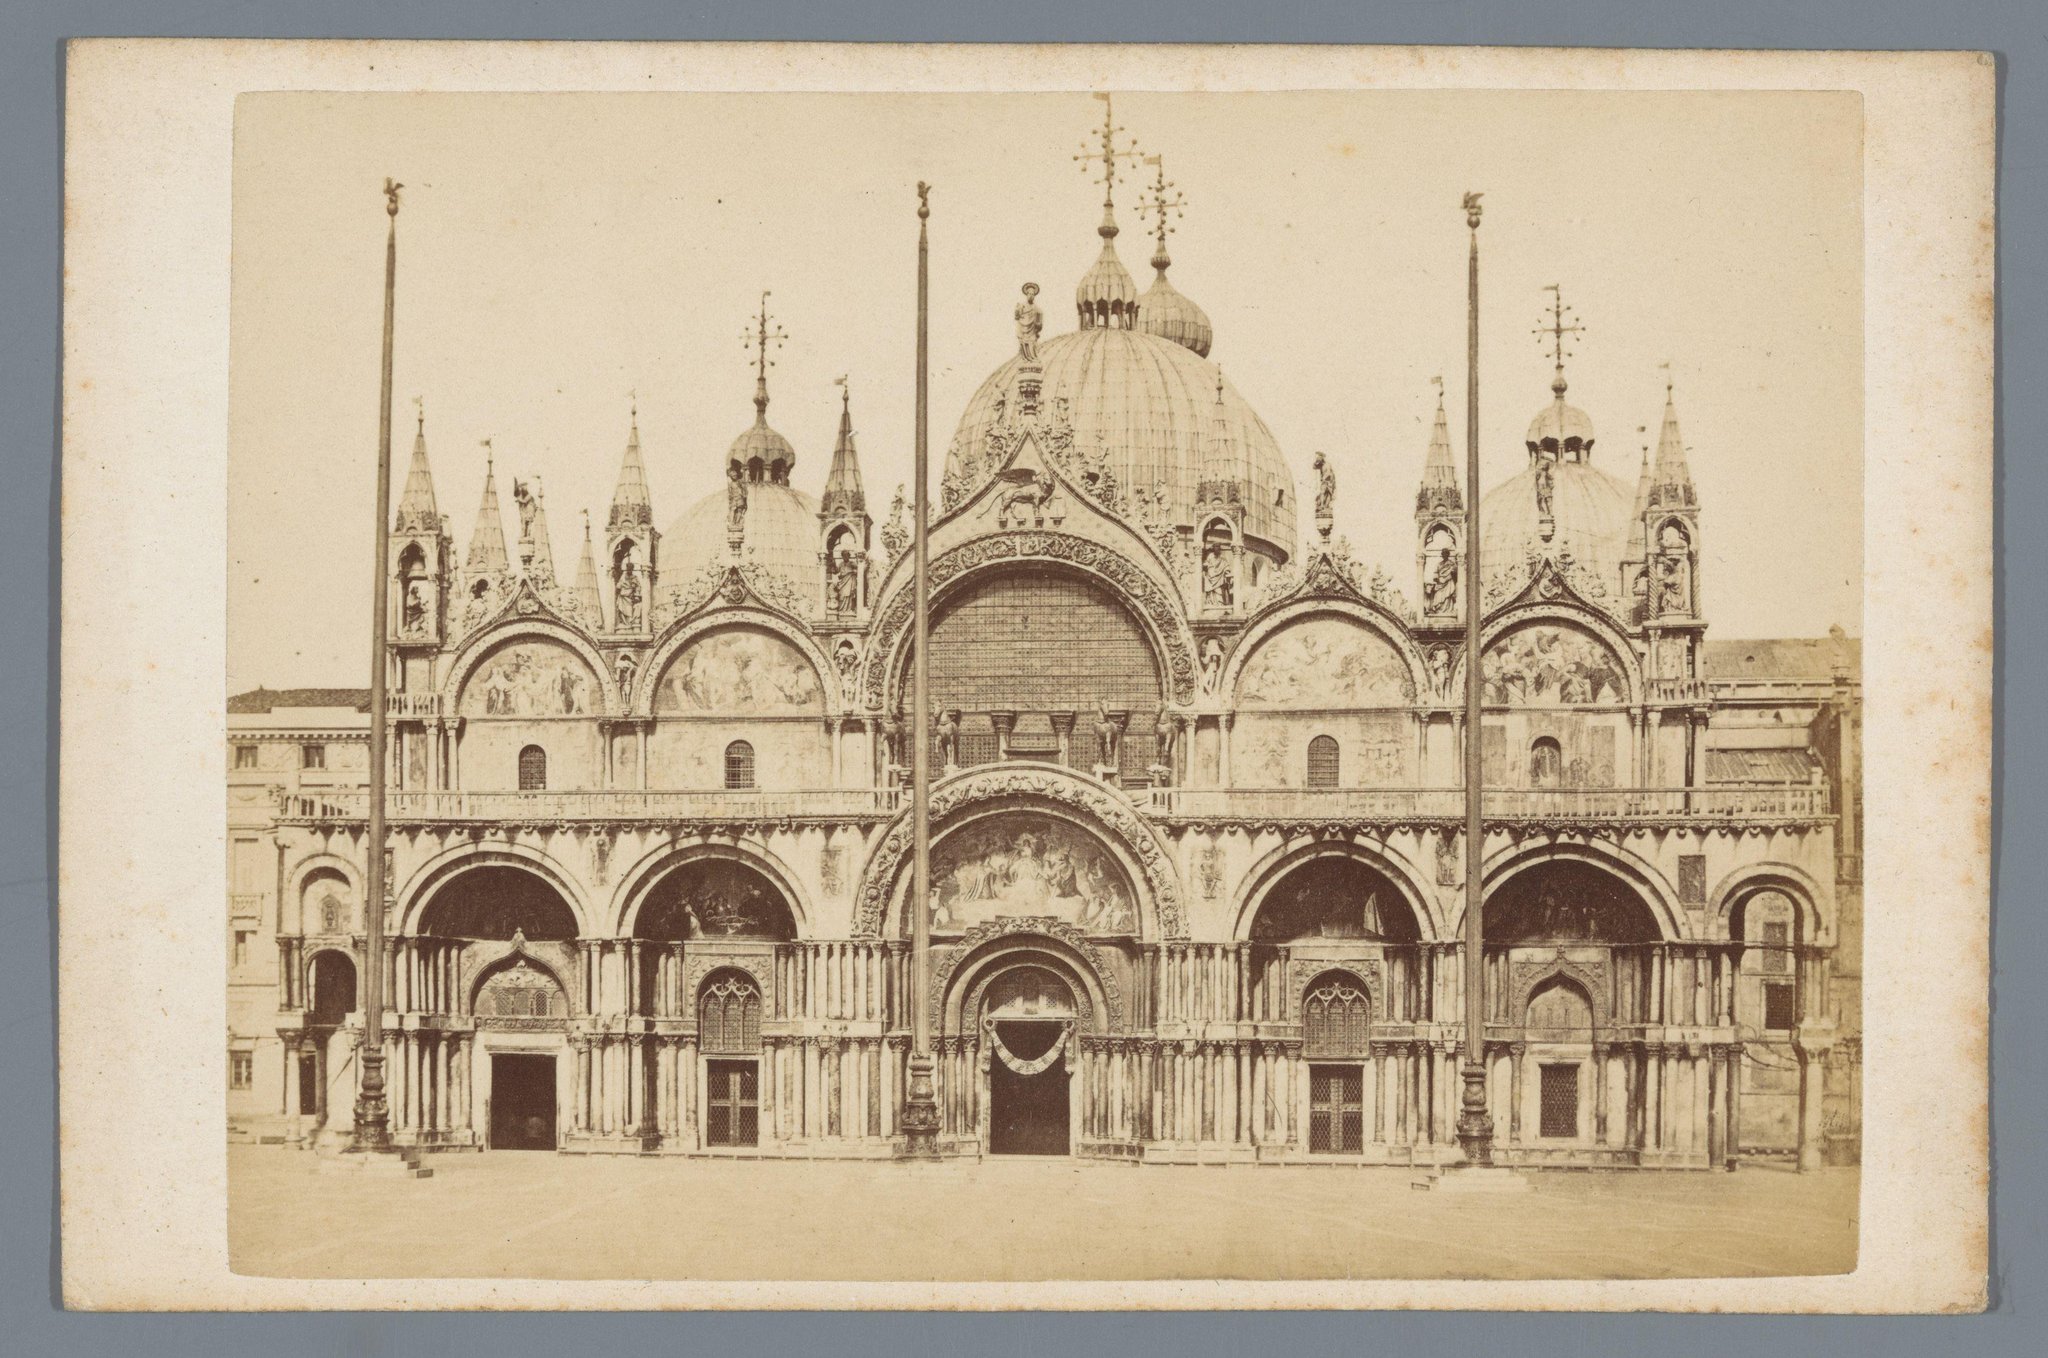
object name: cabinet photograph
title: Gezicht op de façade van de San Marco in Venetië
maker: Anonymous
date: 1850-1900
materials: cardboard, photographic support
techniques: albumen print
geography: st. mark's basilica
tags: church (exterior)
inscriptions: annotation: ‘San Marco’